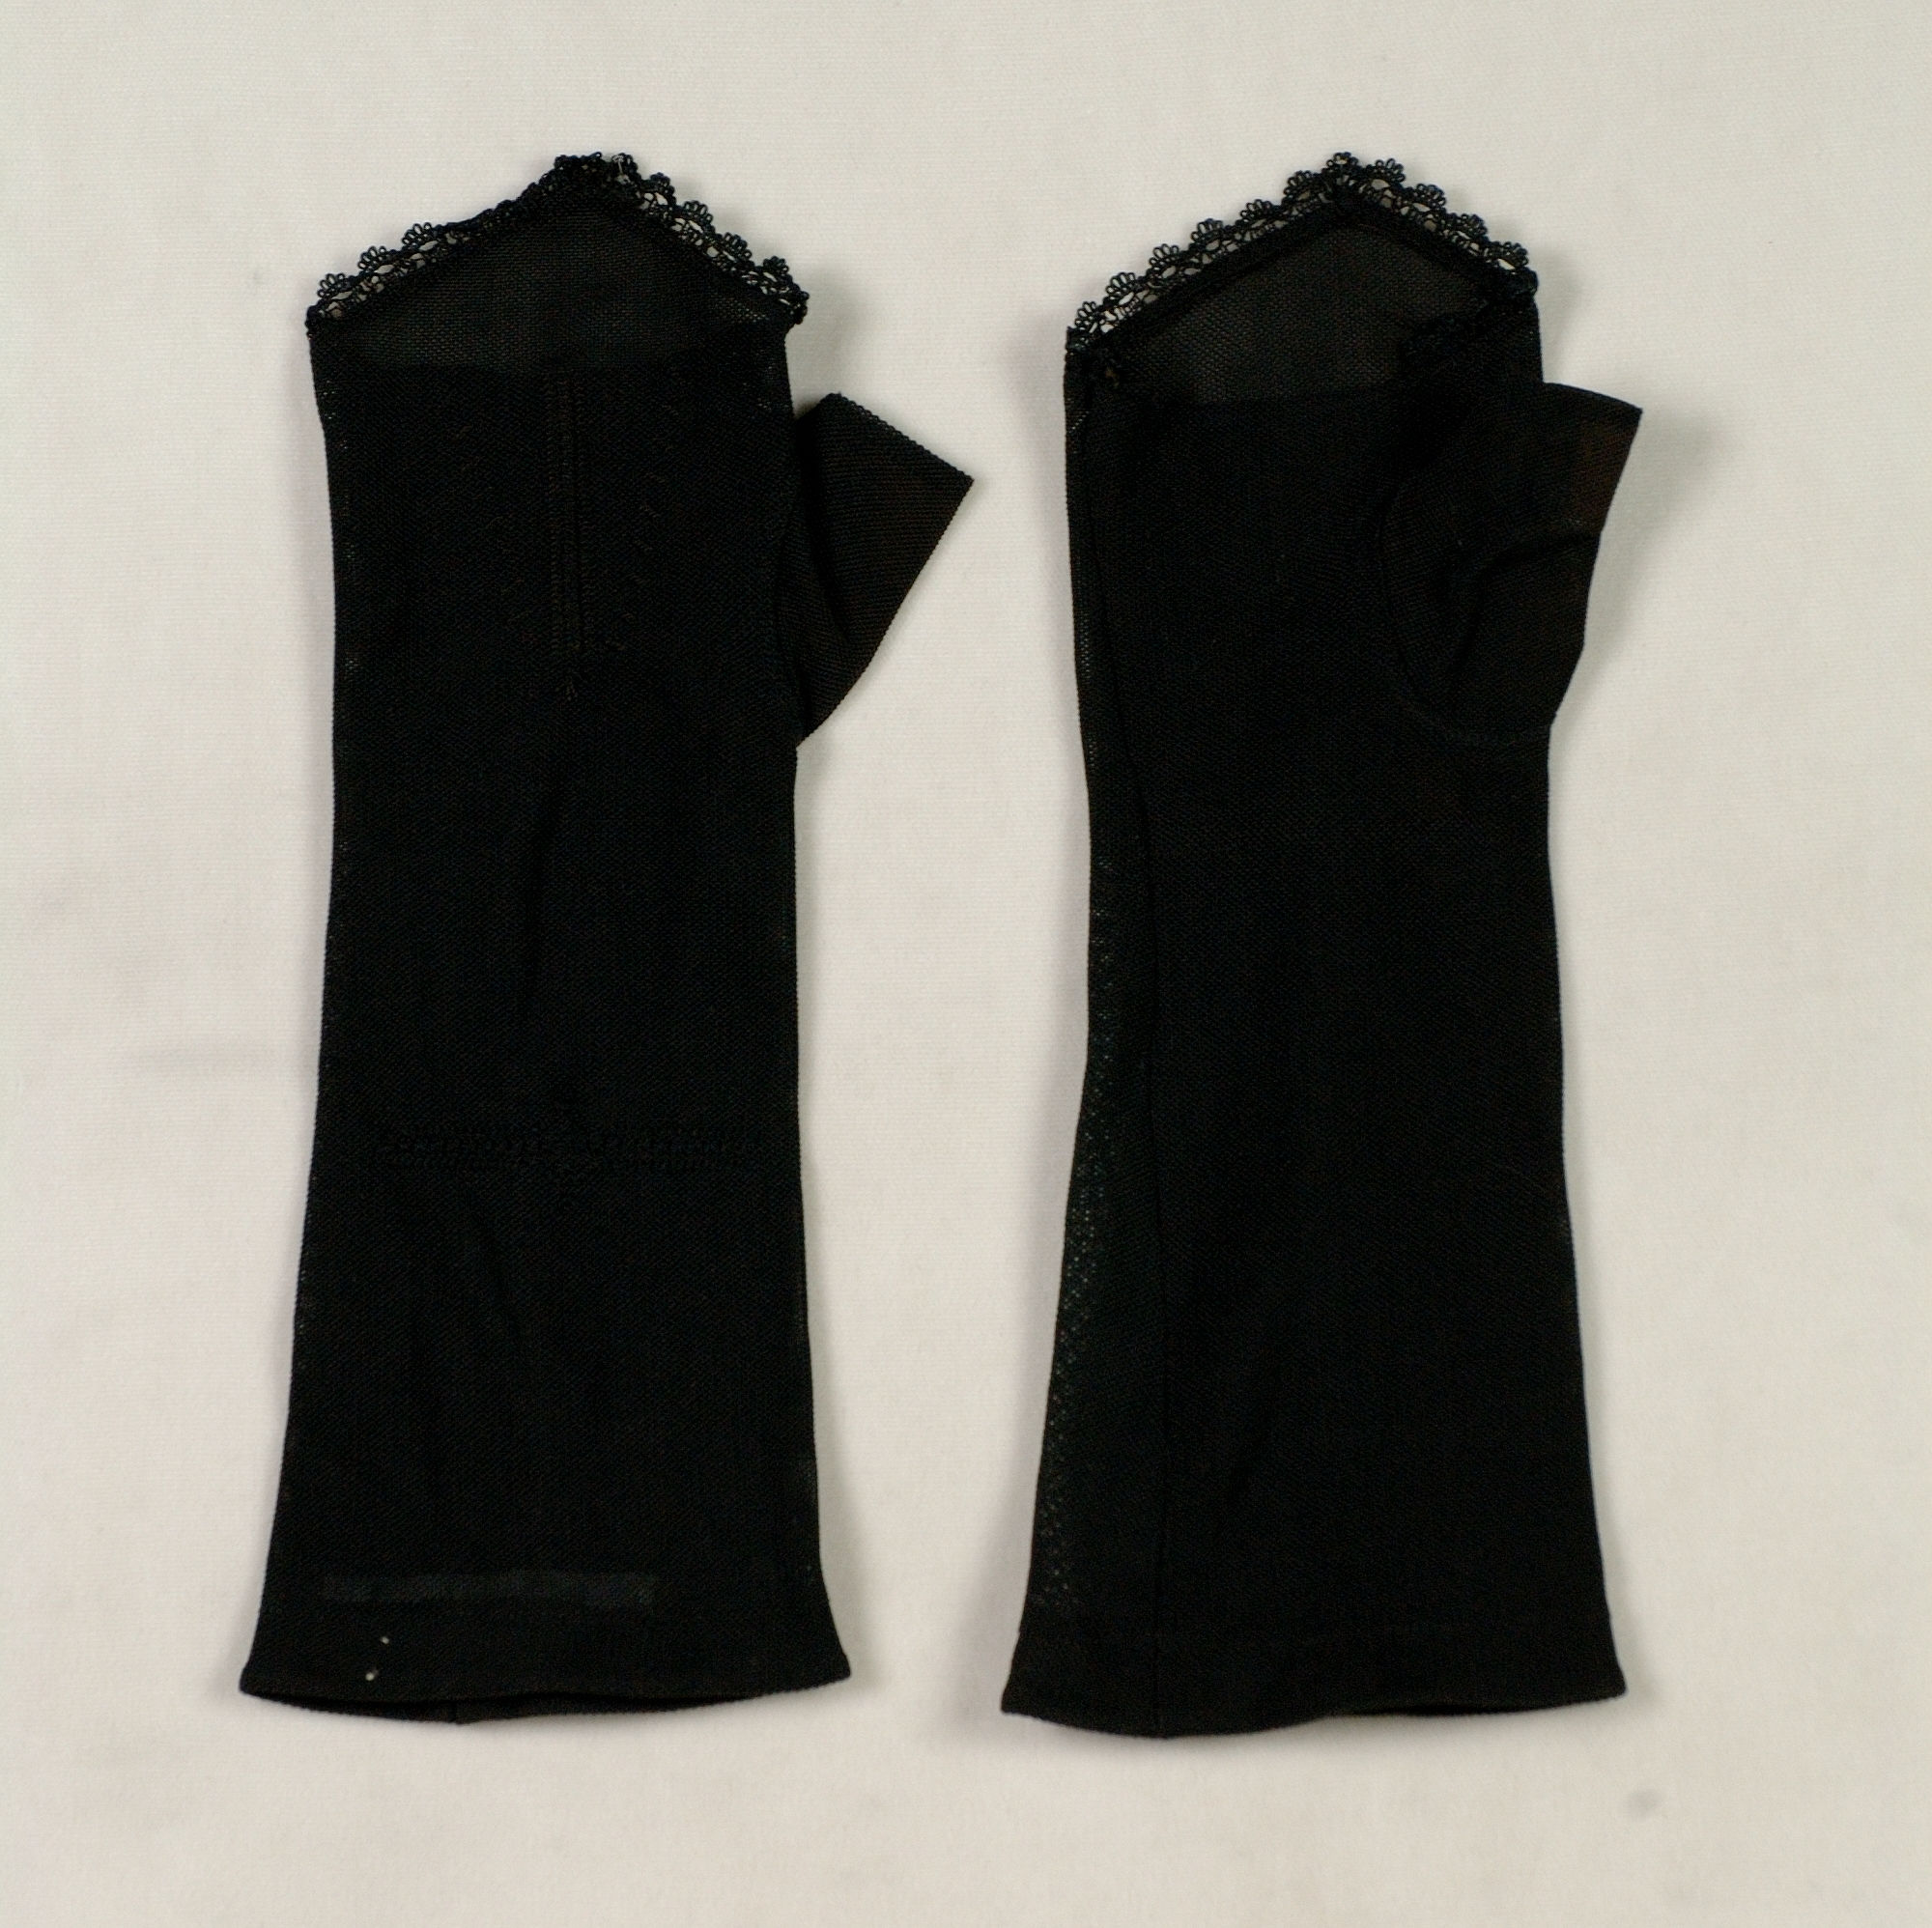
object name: mitt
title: Mitts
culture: american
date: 1840-1860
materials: silk